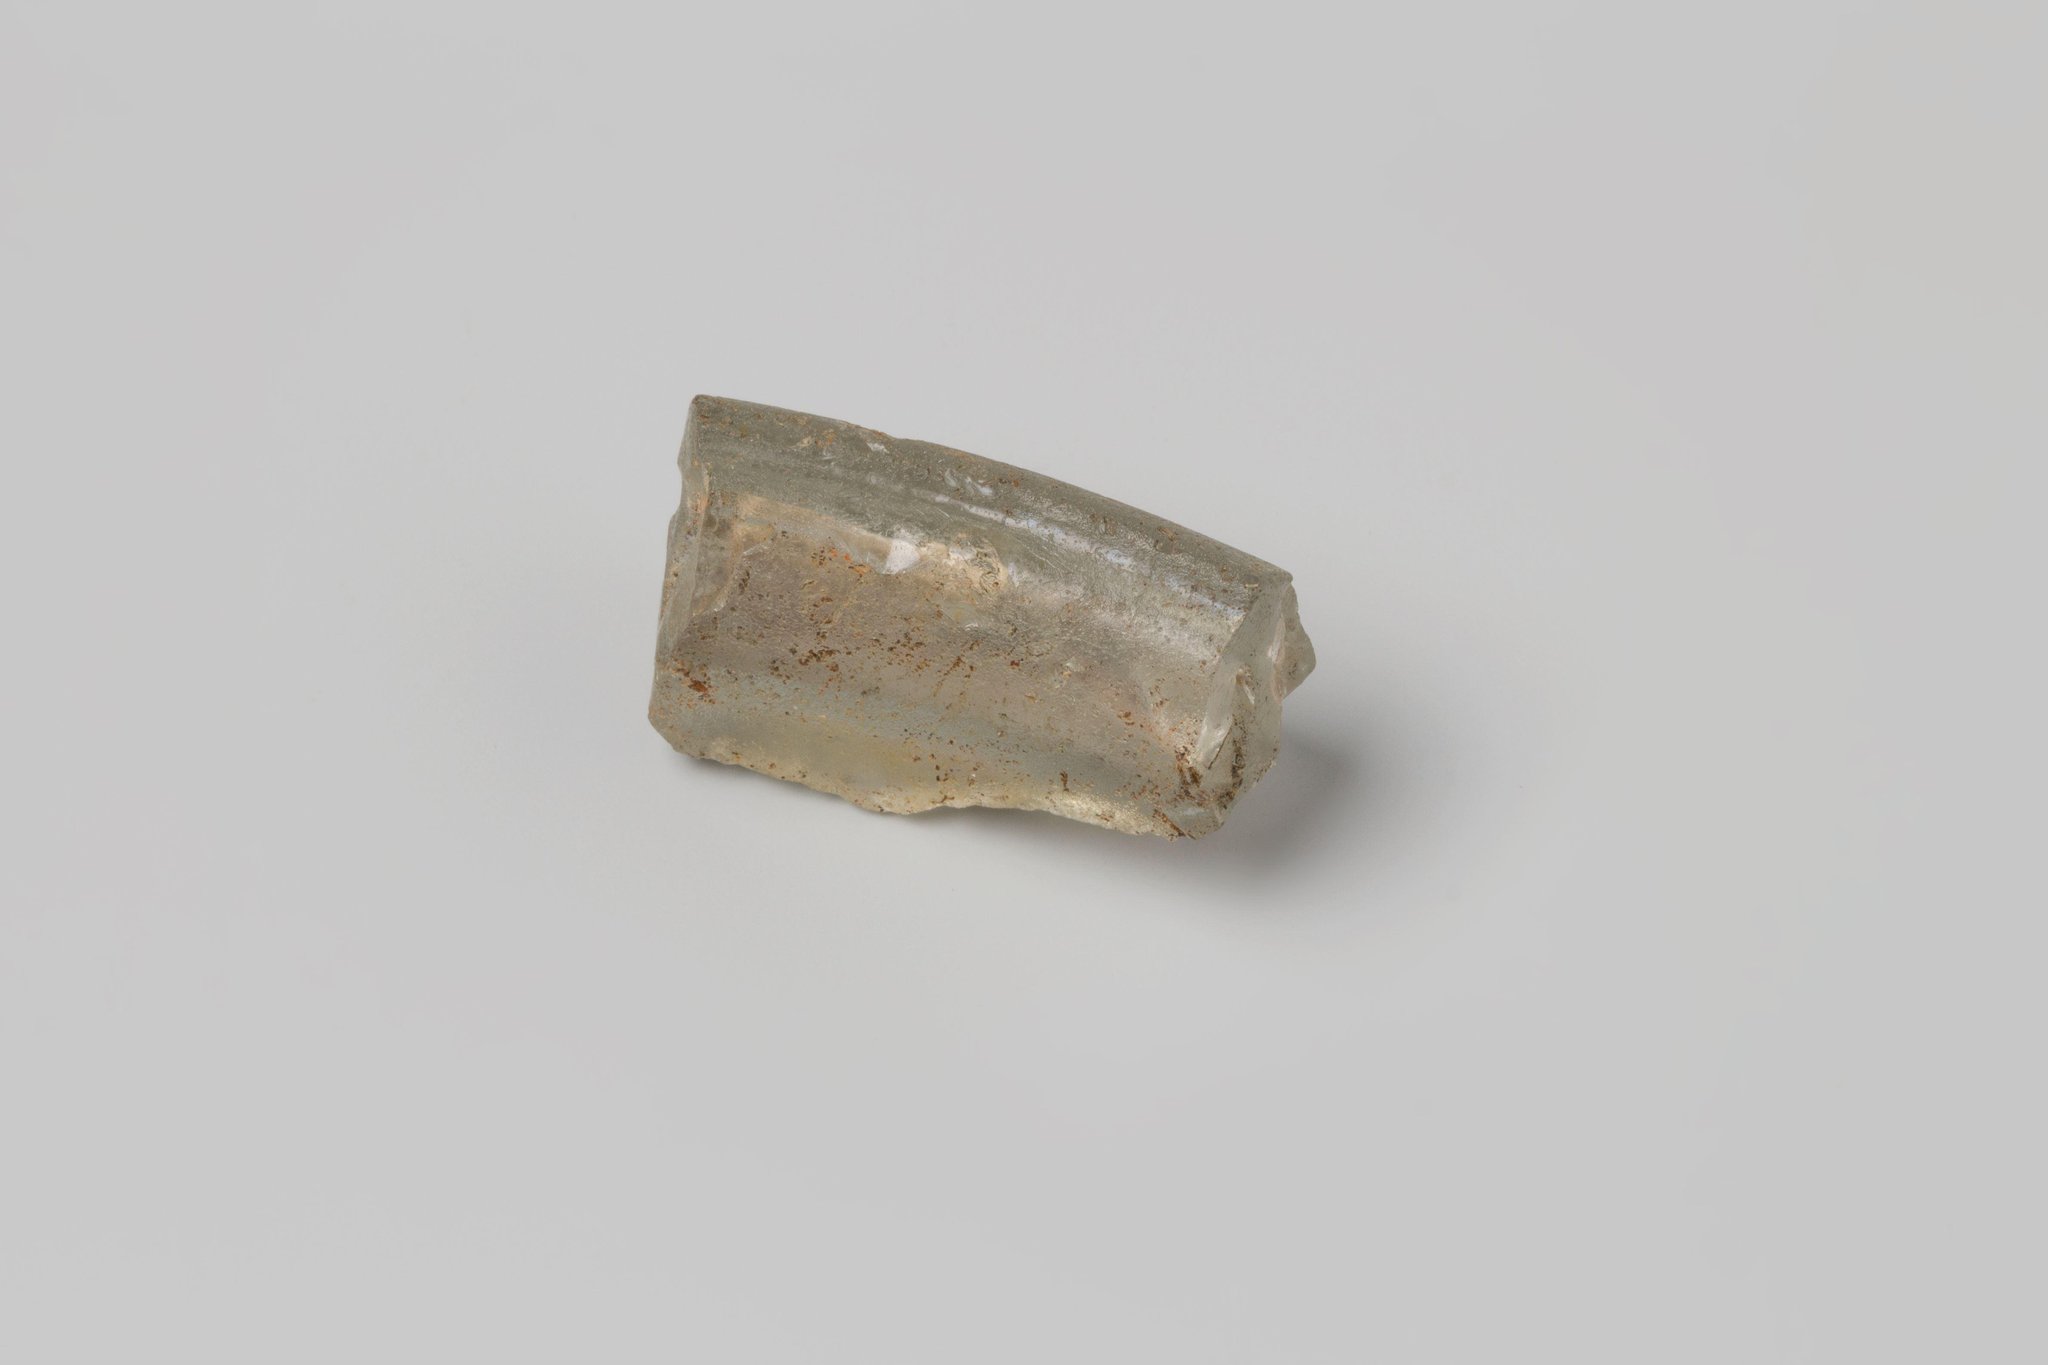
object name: vessel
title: Fragment montuur van een vaatwerk uit het wrak van de Oost-Indiëvaarder Hollandia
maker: Anonymous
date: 1700-1743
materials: glass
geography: netherlands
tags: verenigde oostindische compagnie, hollandia (schip), annet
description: Vessel part, rim; fragment of curved, fold-over outer rim, convex, stepped inner border, hollow core.